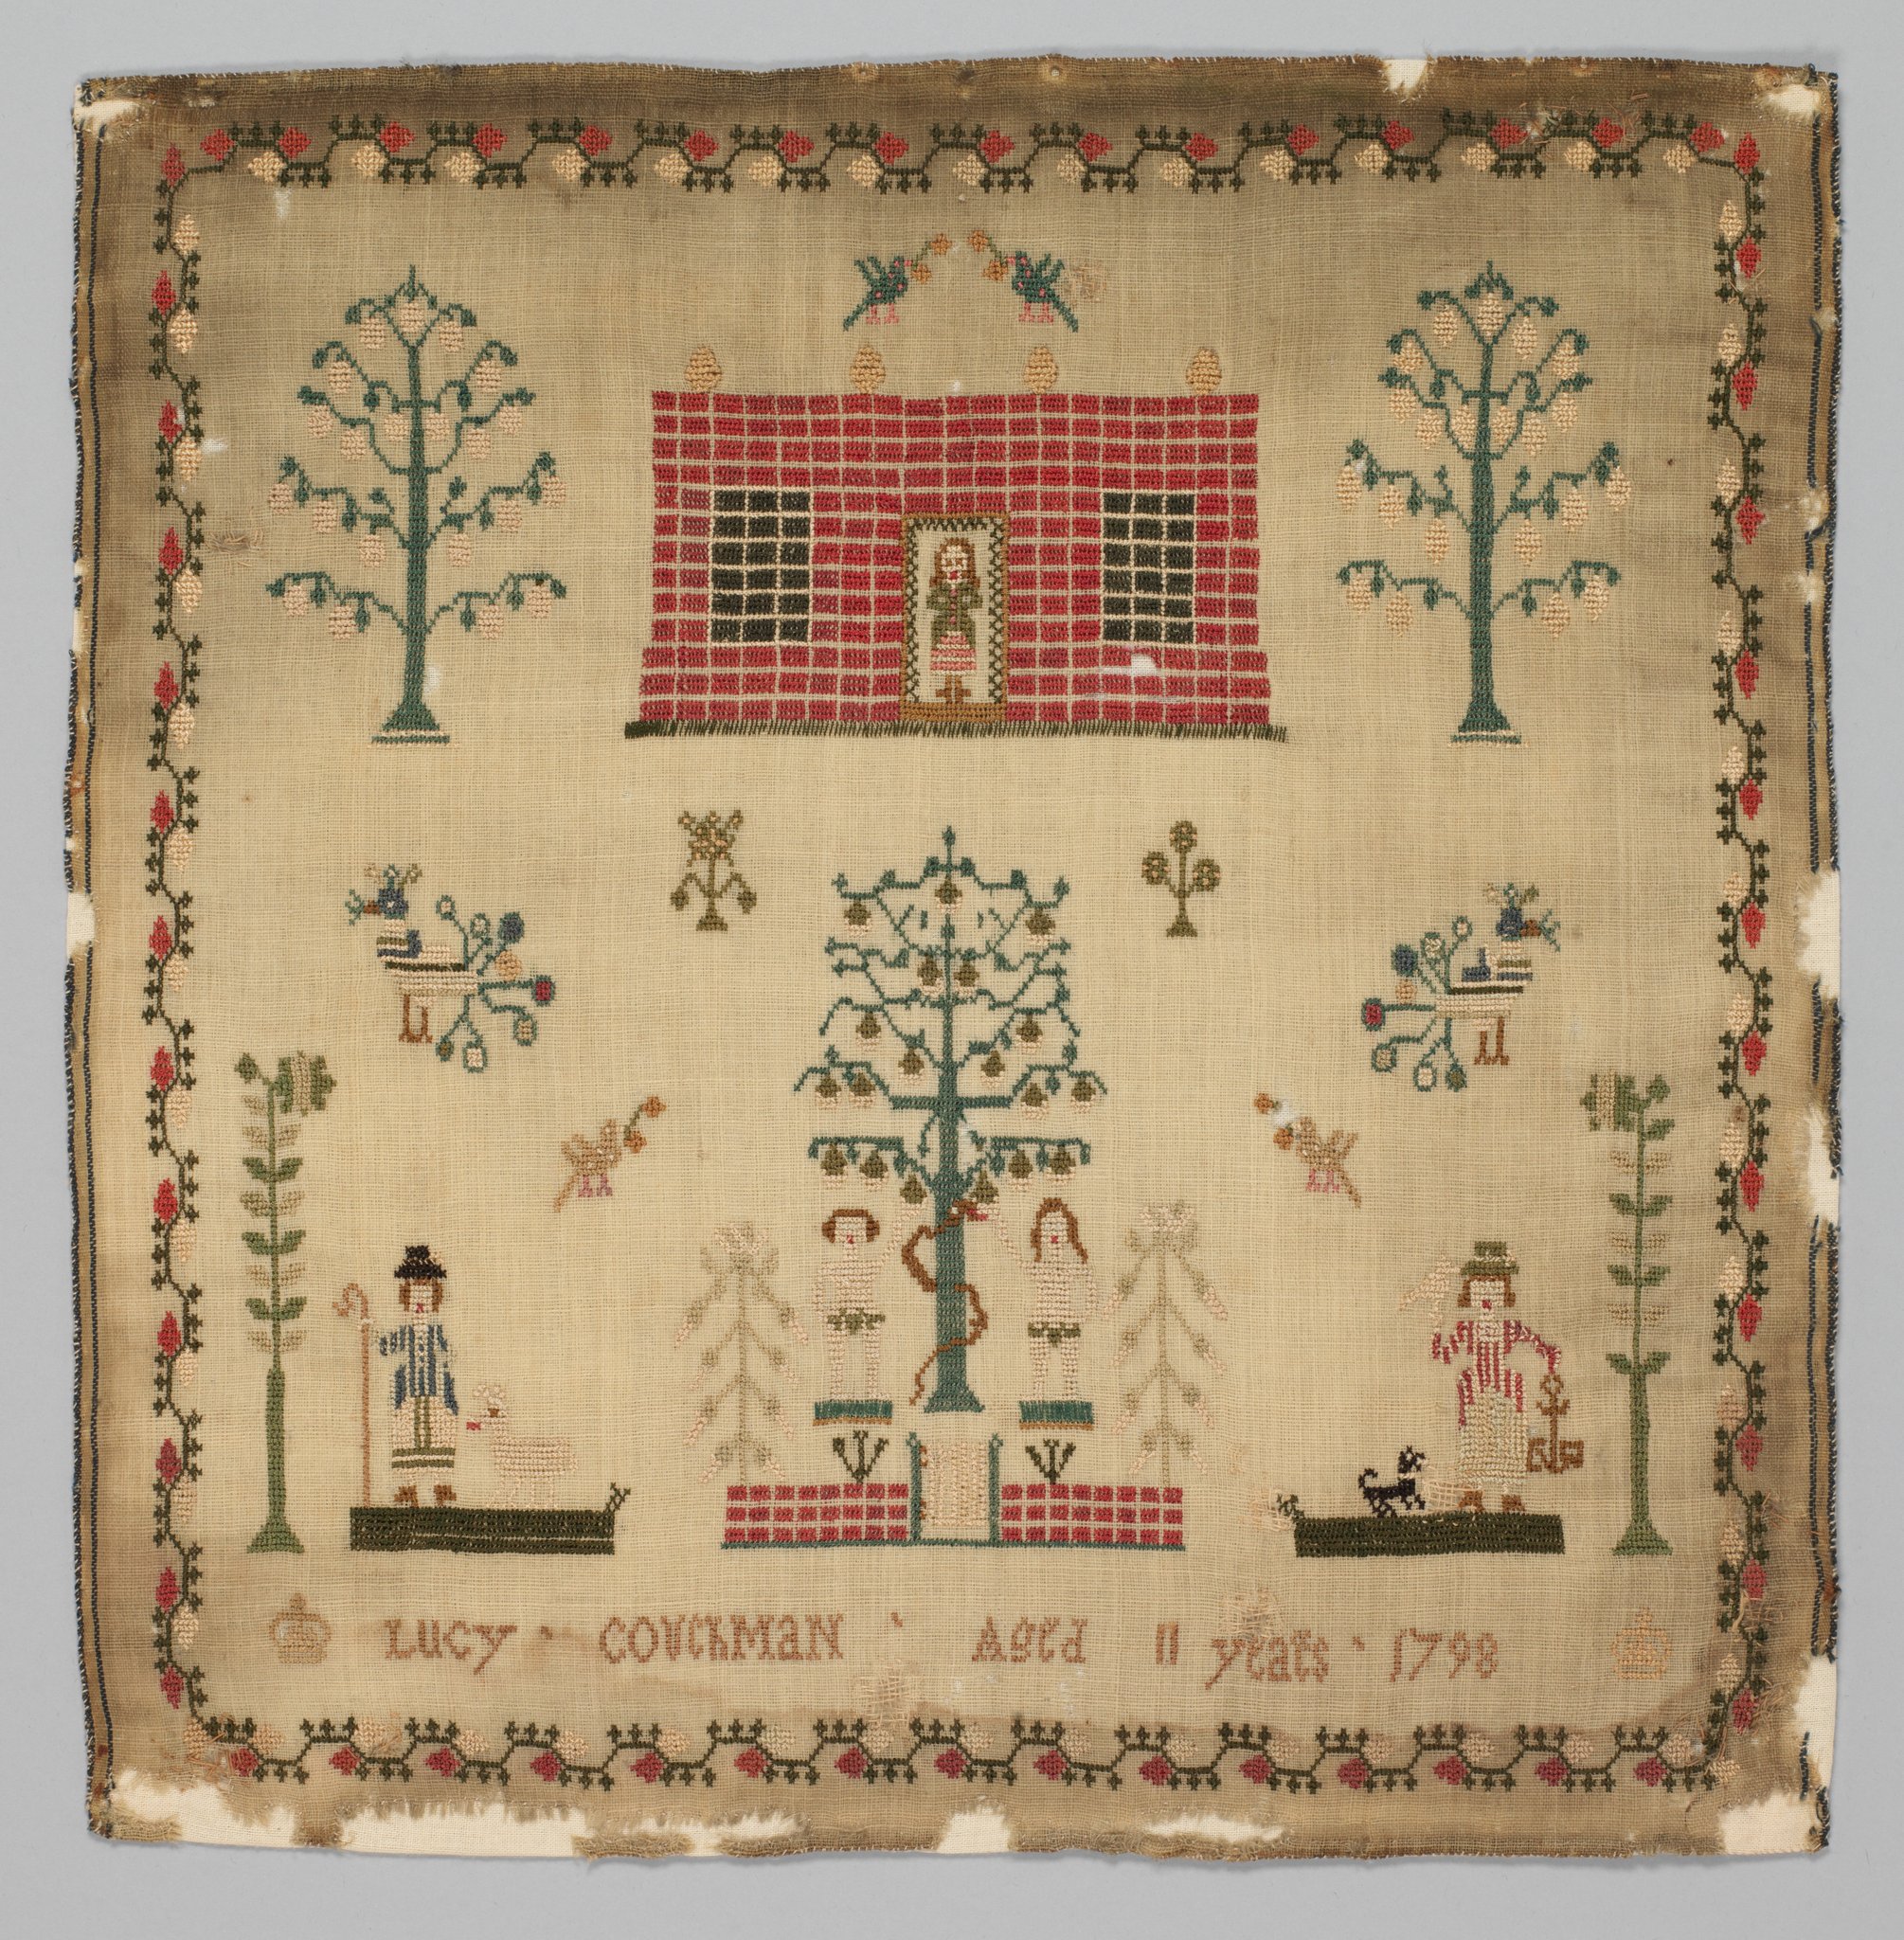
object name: sampler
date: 1798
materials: canvas, silk, wool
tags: human figures,birds,trees